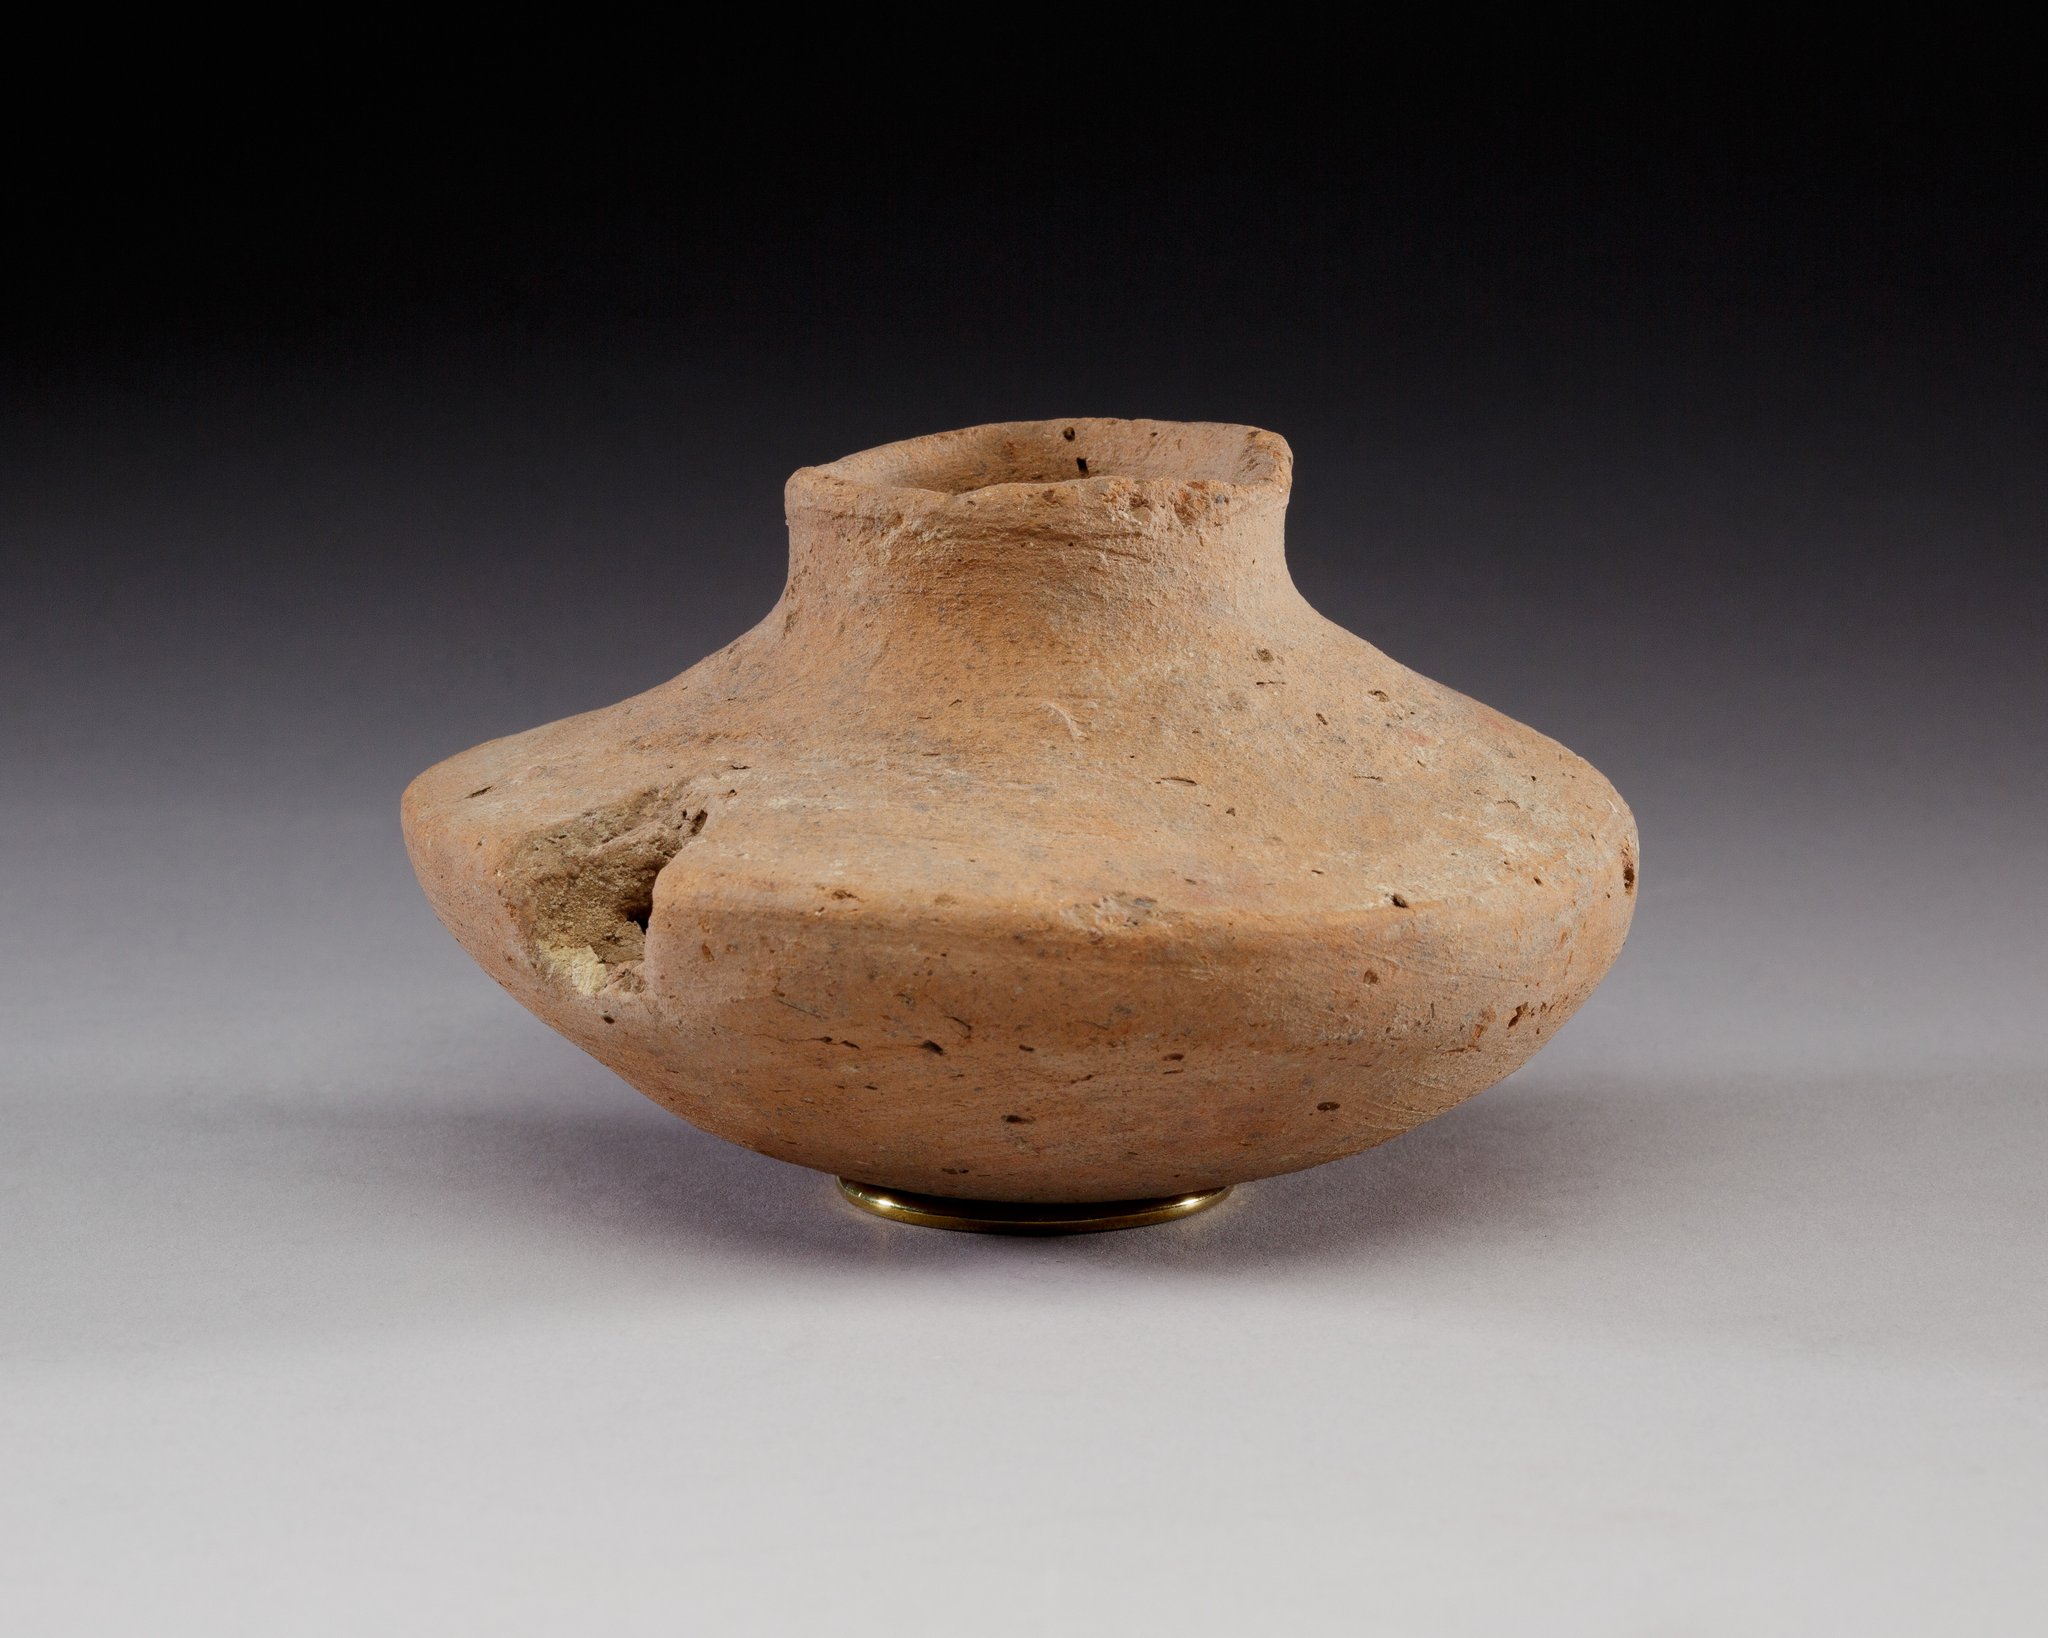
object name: lamp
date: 1900-1850 BCE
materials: pottery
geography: egypt